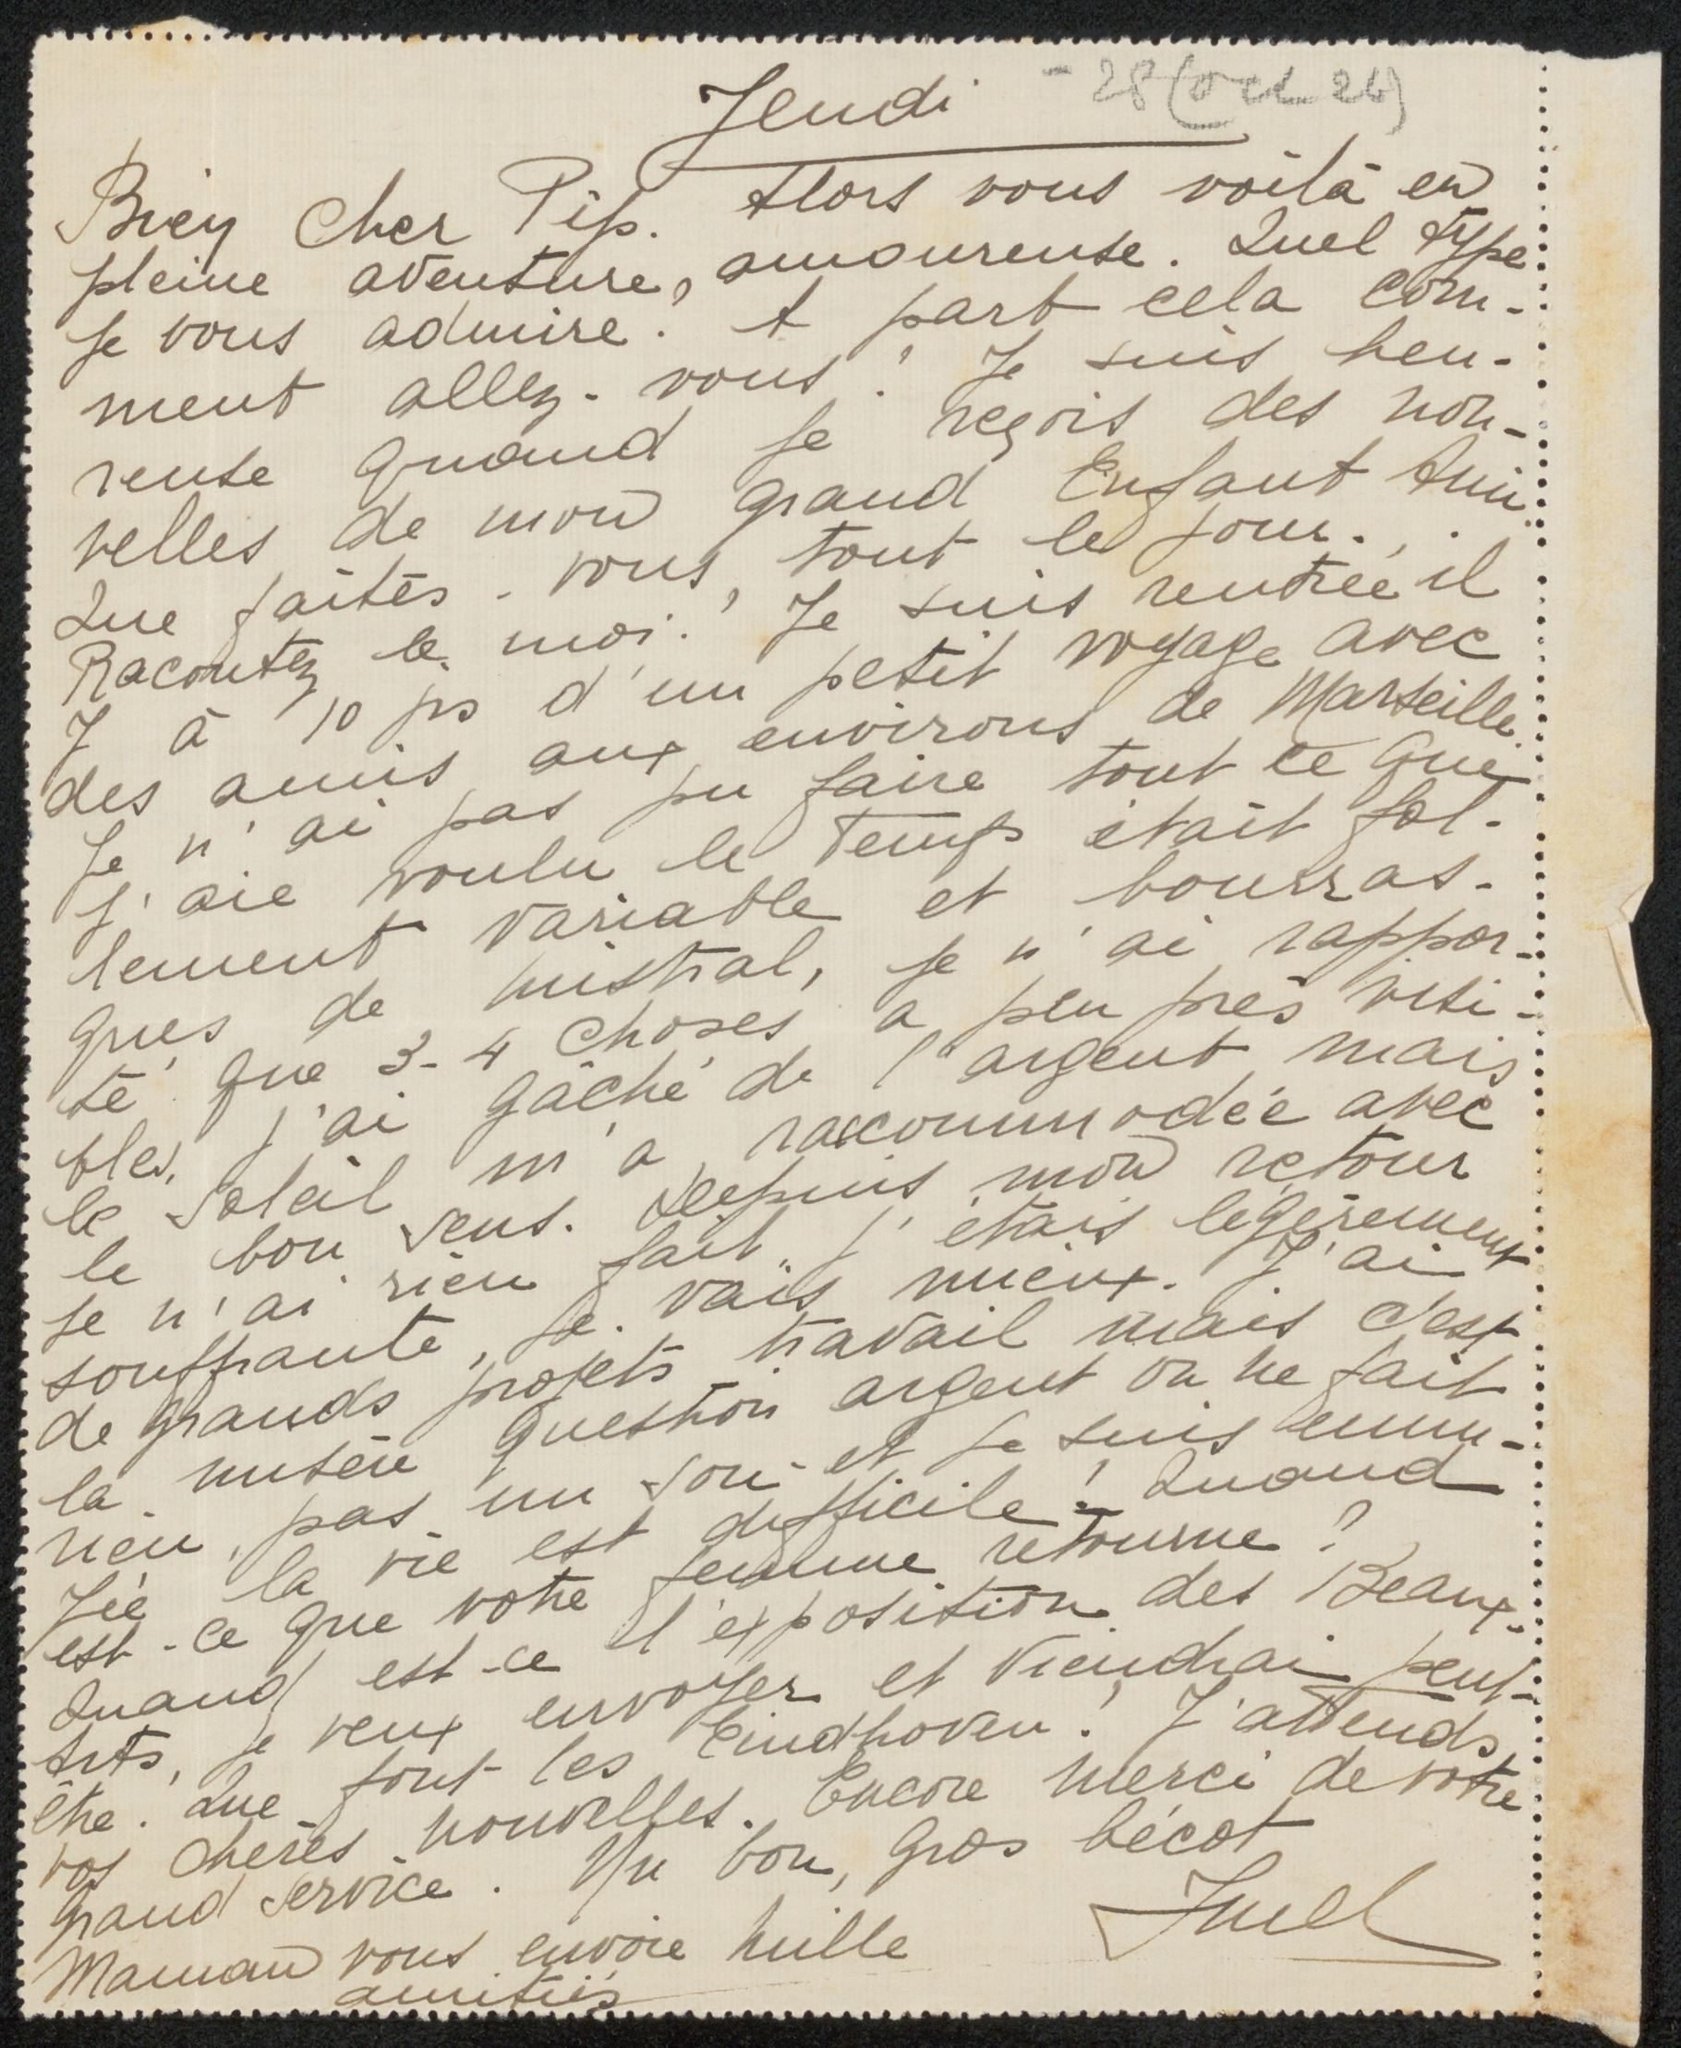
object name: letter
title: Brief aan Philip Zilcken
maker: rose imel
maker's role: draughtsman, painter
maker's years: 1901-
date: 1911-1930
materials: ink, paper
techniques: pen, writing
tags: the hague, painter, draughtsman, philip zilcken, travelling; tourism, exhibition ~ art, marseille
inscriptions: collector's mark: ‘RPK’